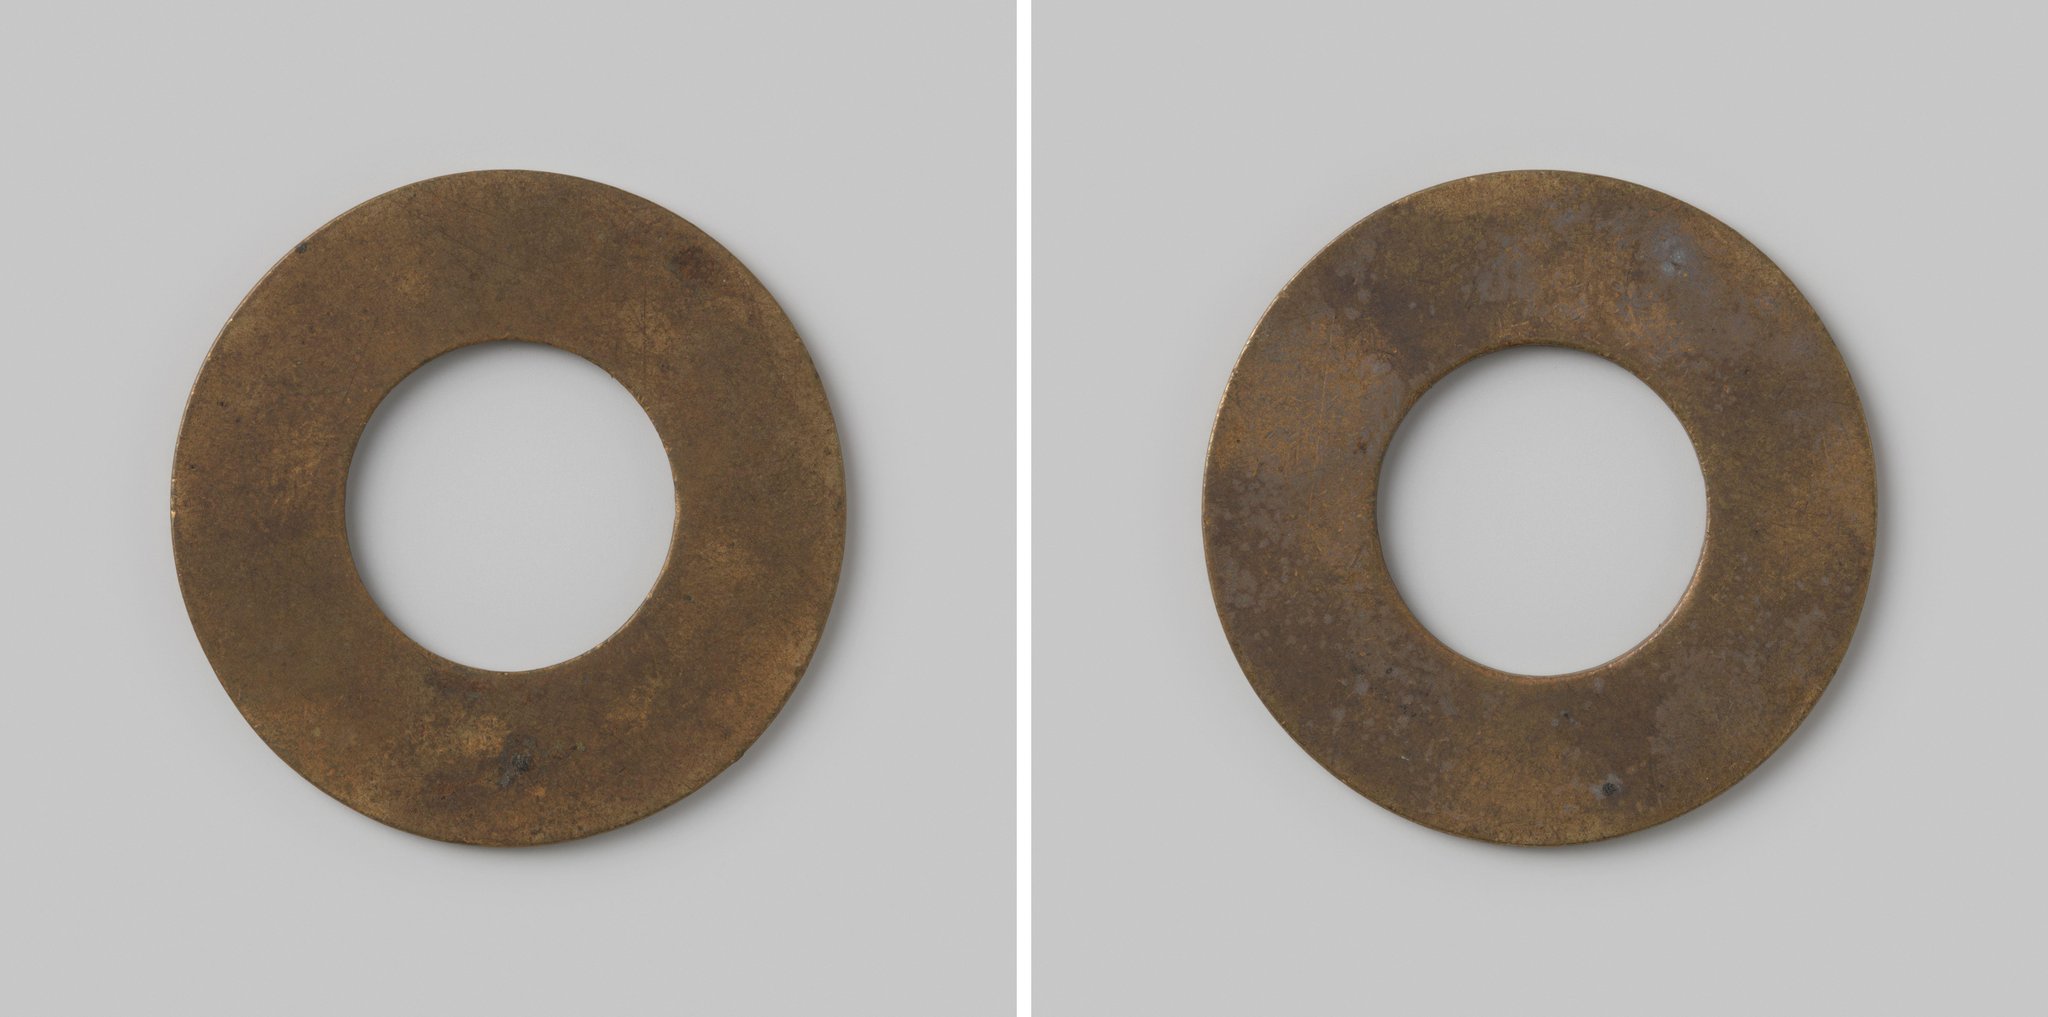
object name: history medal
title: Betaalpenning van 1 gulden van Hotel-Cafe Du Commerce te Amsterdam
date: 1875-1900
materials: brass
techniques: manufacturing